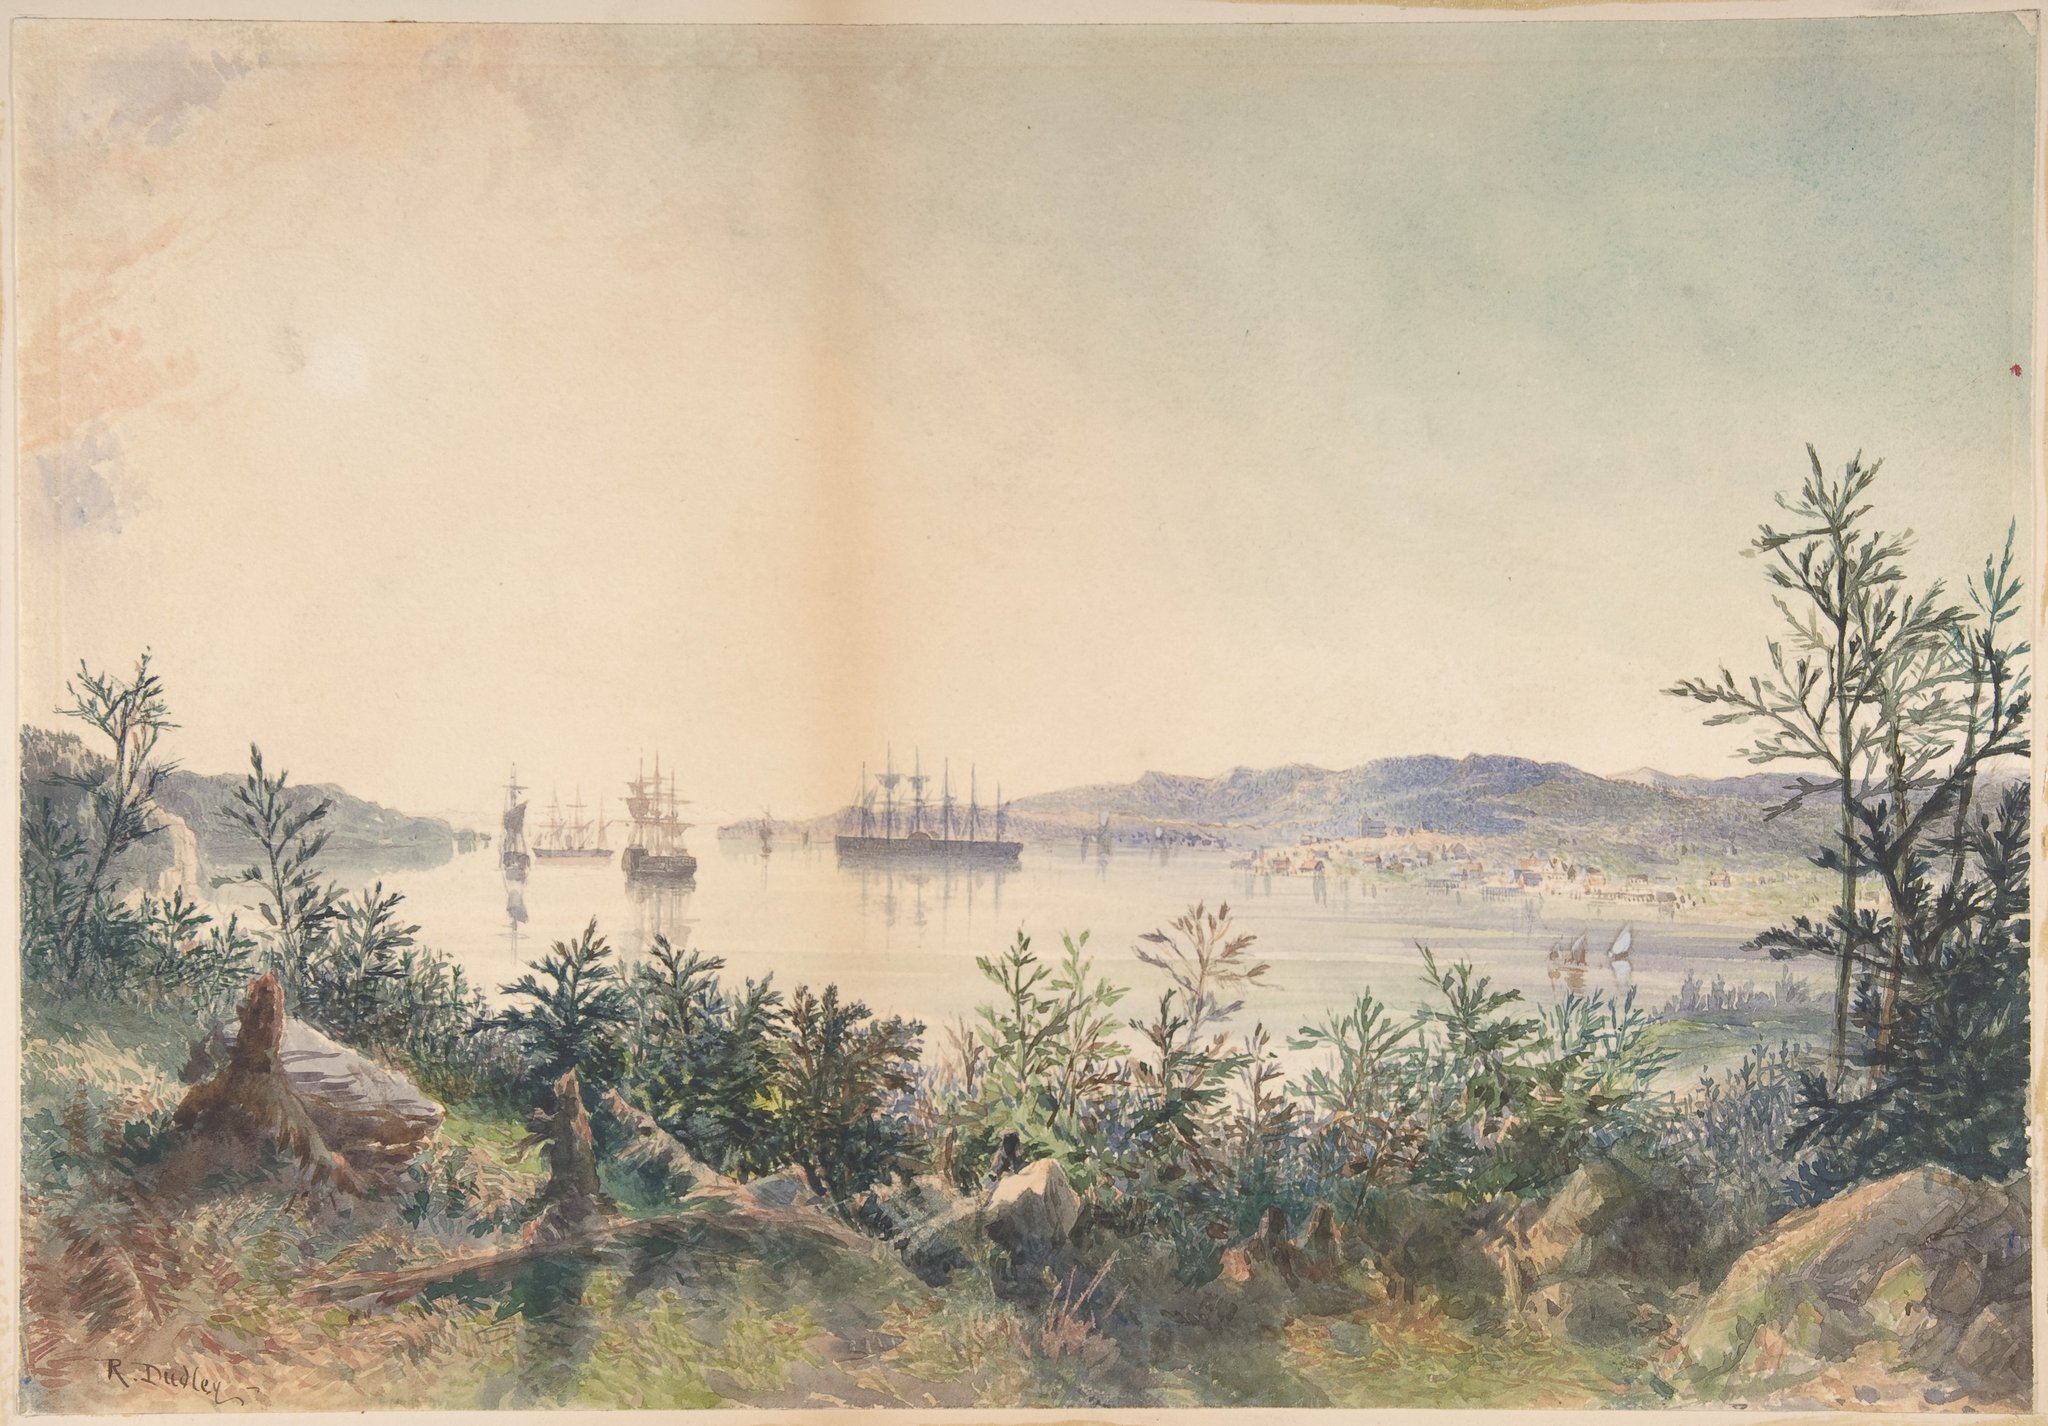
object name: drawing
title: Arrival in Trinity Bay, Newfoundland: The Cable Passed to the Paddle-box Boat of the Terrible, etc.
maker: robert charles dudley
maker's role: artist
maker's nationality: british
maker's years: 1826-1909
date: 1866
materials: gouache, graphite, watercolor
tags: landscapes,boats,transatlantic cable